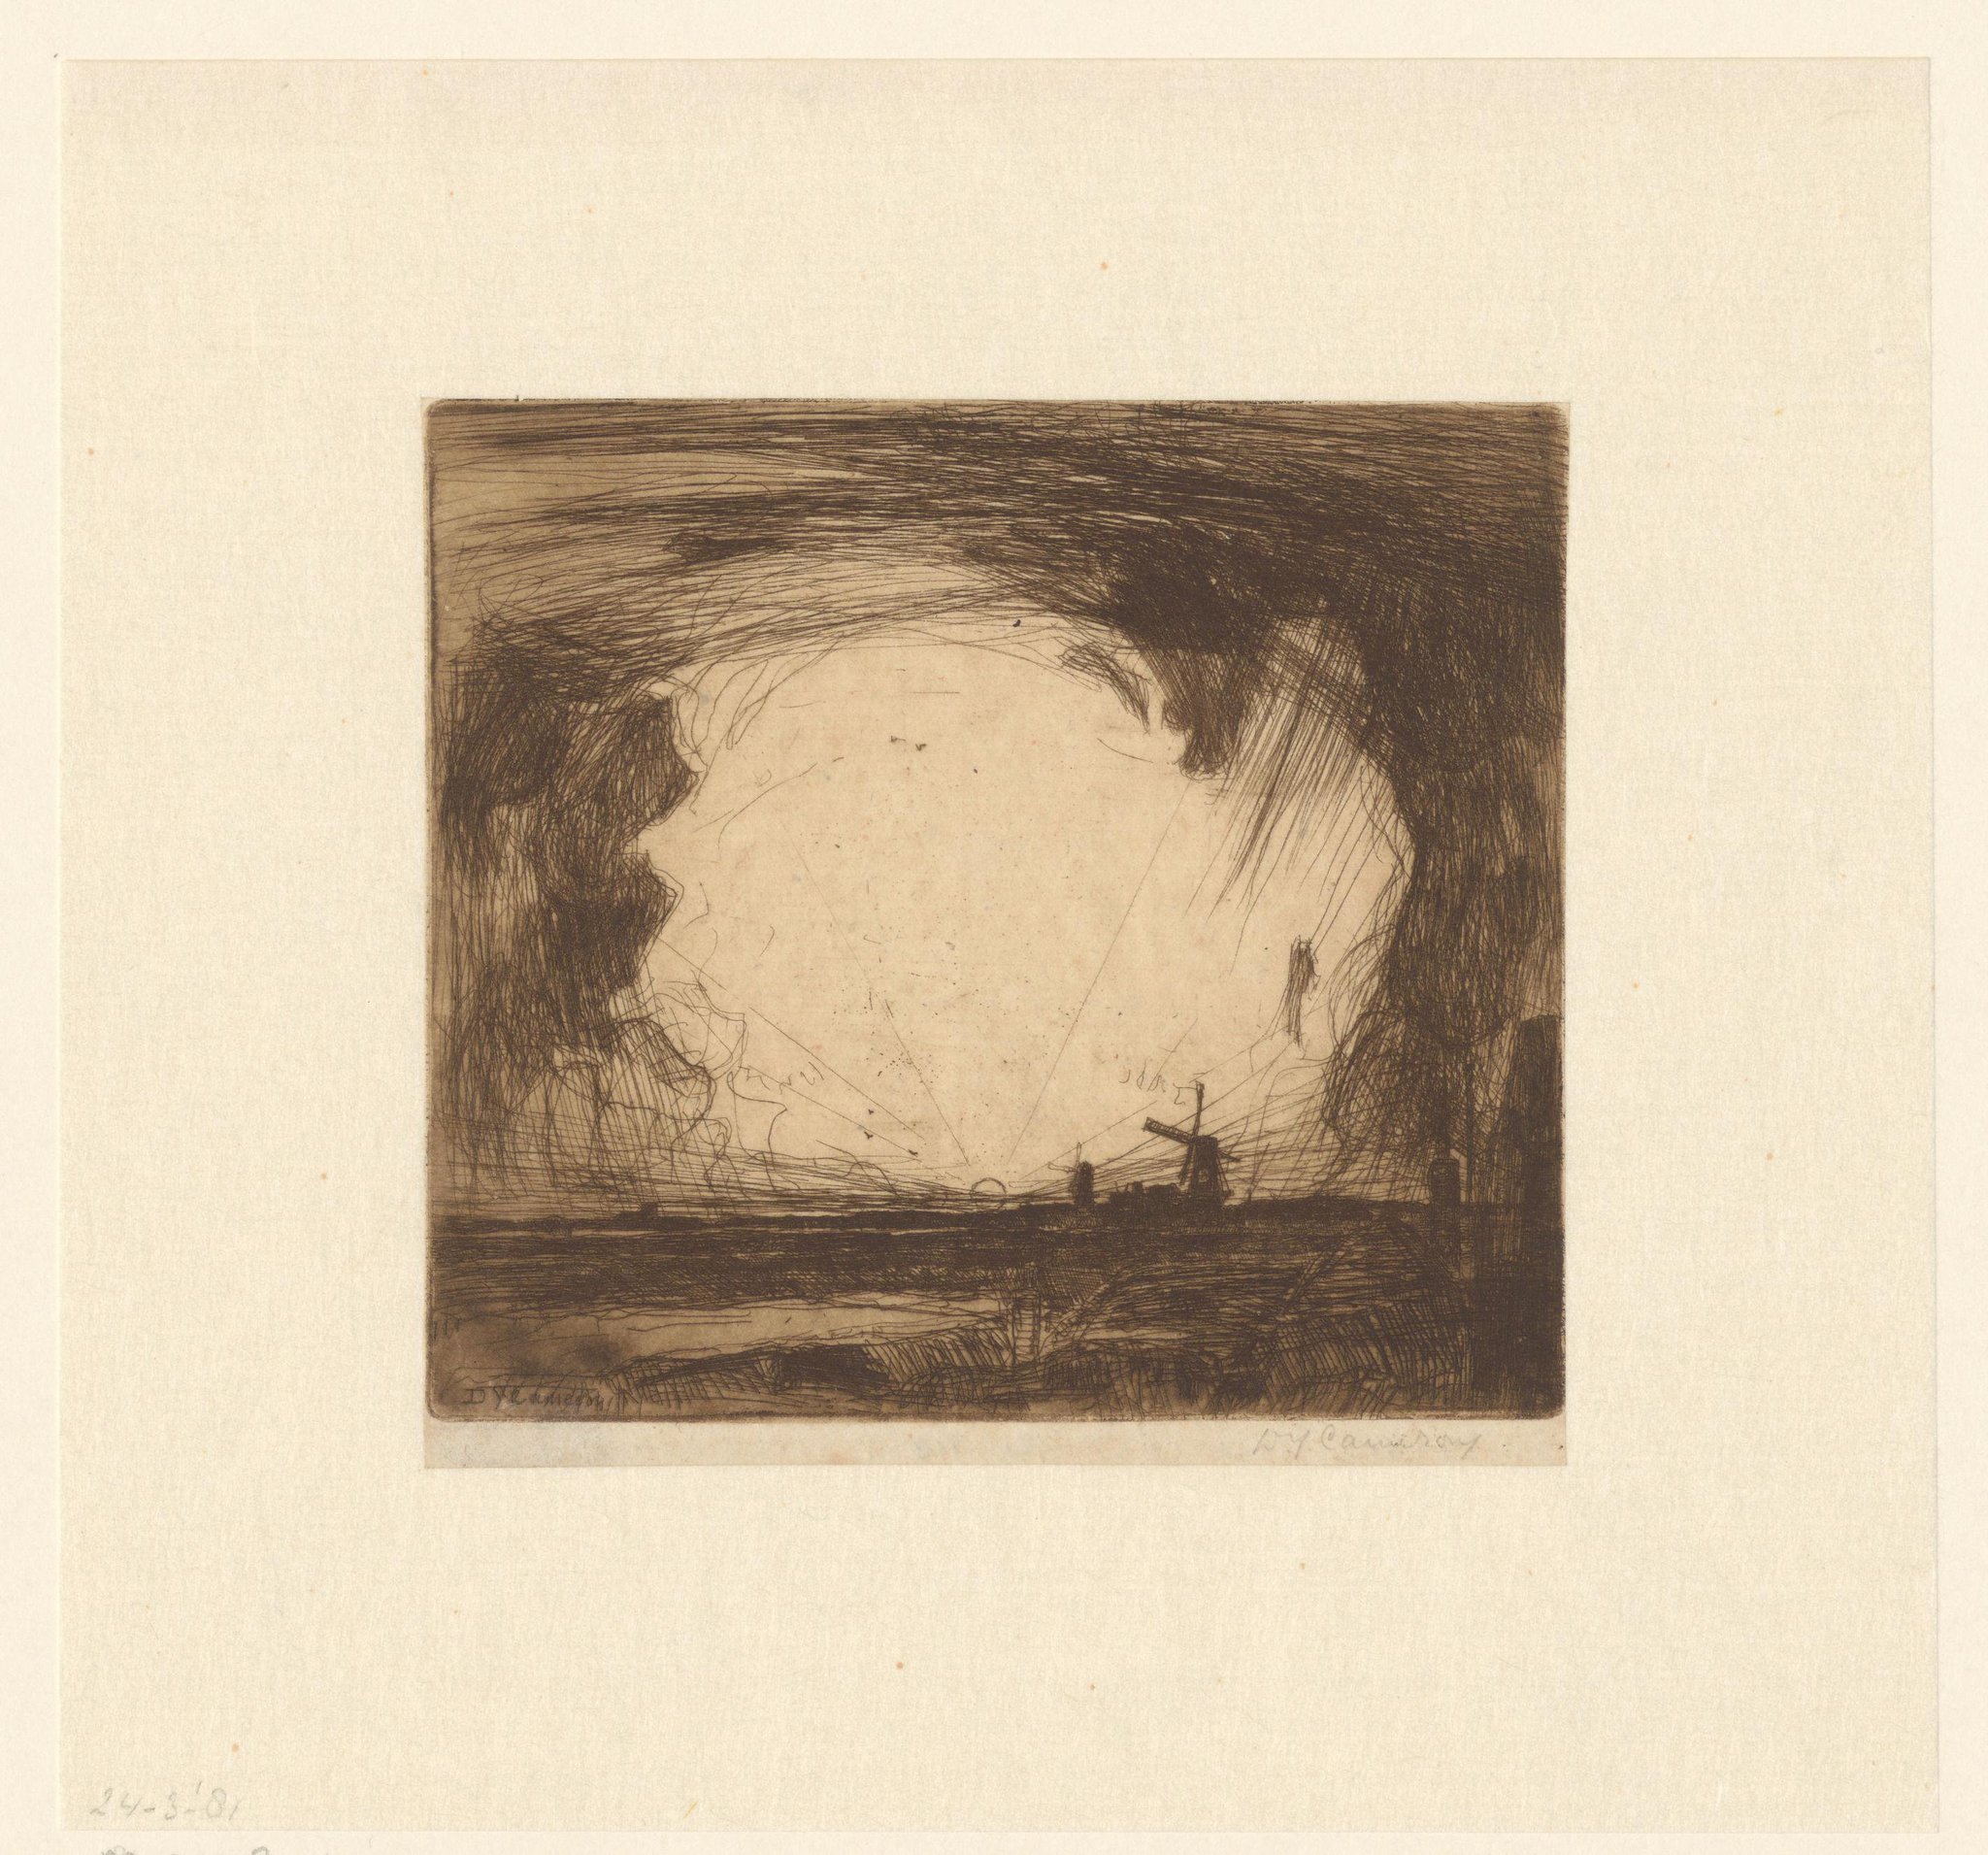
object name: print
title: Landschap met windmolens tijdens een storm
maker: david young cameron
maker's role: draughtsman, print maker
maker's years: 1865-1945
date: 1892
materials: paper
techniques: drypoint, etching, intaglio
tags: windmill in landscape, storm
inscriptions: collector's mark: Lugt 2228, collector's mark: Lugt 2760